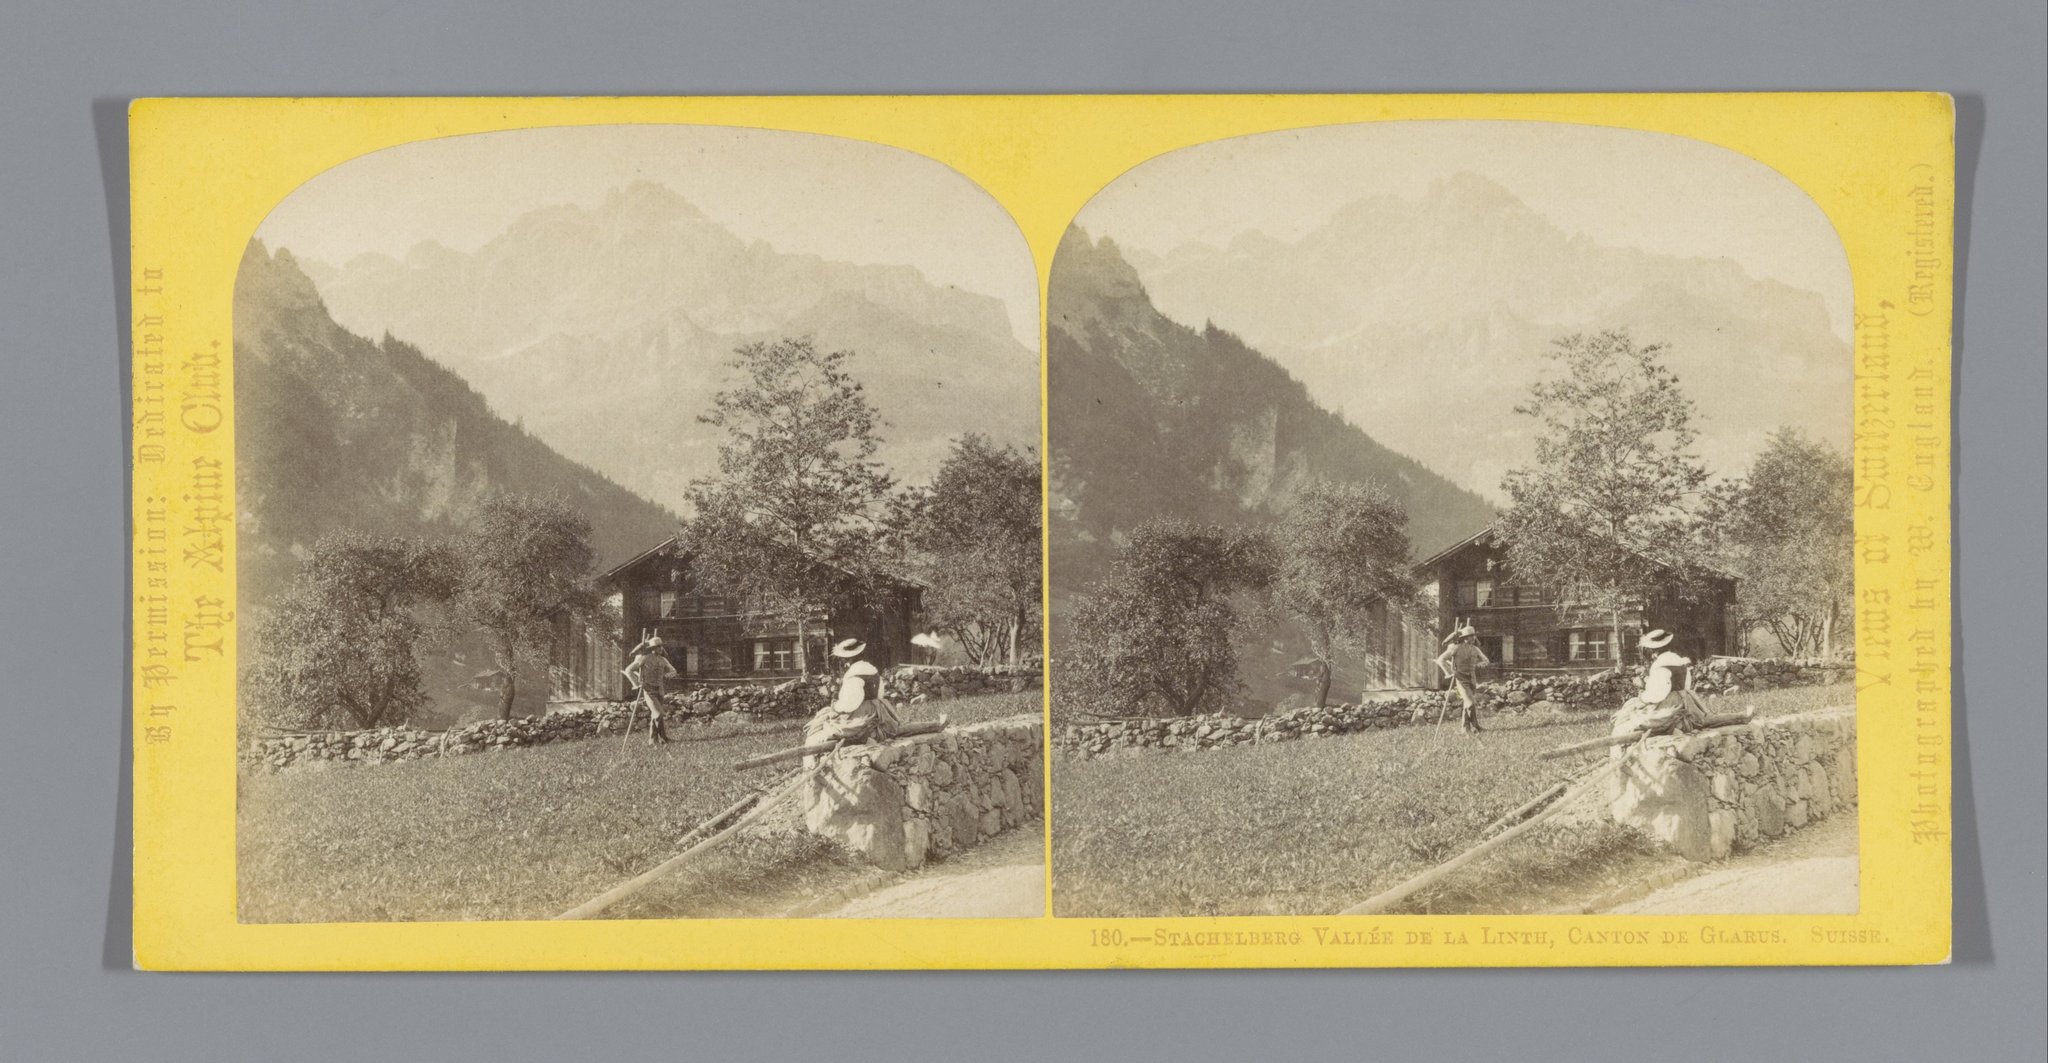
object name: stereograph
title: Gezicht op de Linthvallei, met op de voorgrond een berghut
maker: william england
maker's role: fotograaf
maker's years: 1816-1896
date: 1850-1880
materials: cardboard, photographic support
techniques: albumen print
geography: glarus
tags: dale, valley, façade (of house or building), mountains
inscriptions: inscription: ‘Views of Switzerland, photographed by W. England. (Registered) Under the Special Patronage of the Alpine Club.’, number: ‘180.’